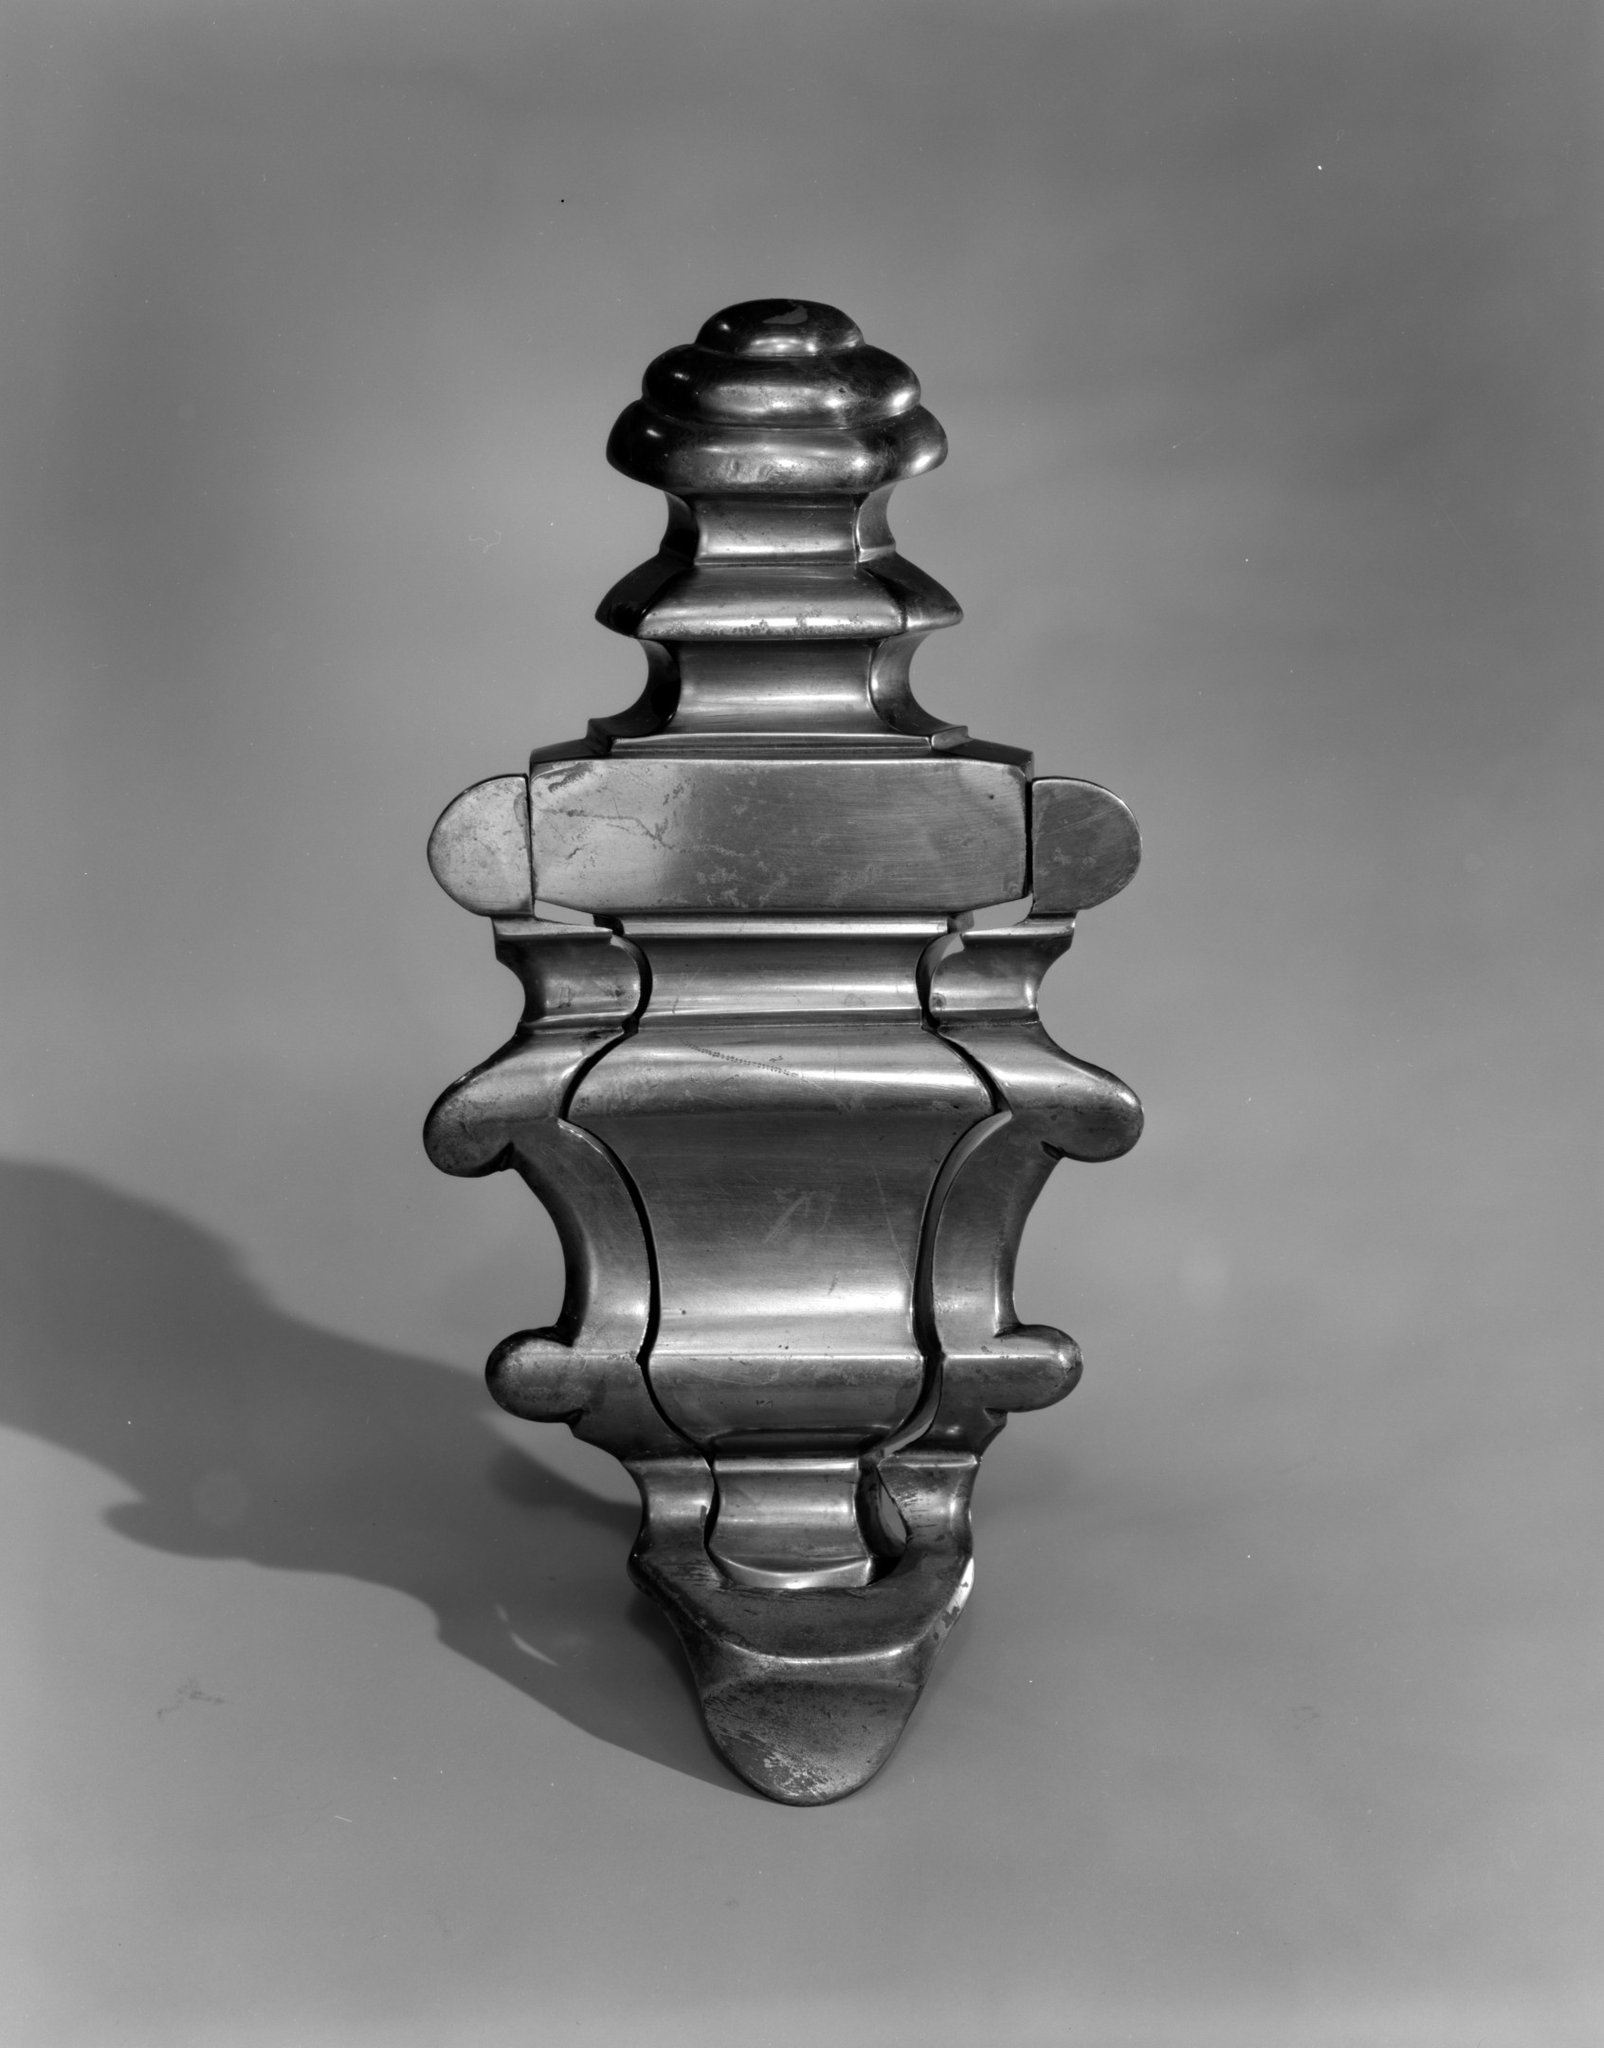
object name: knocker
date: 1820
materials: brass